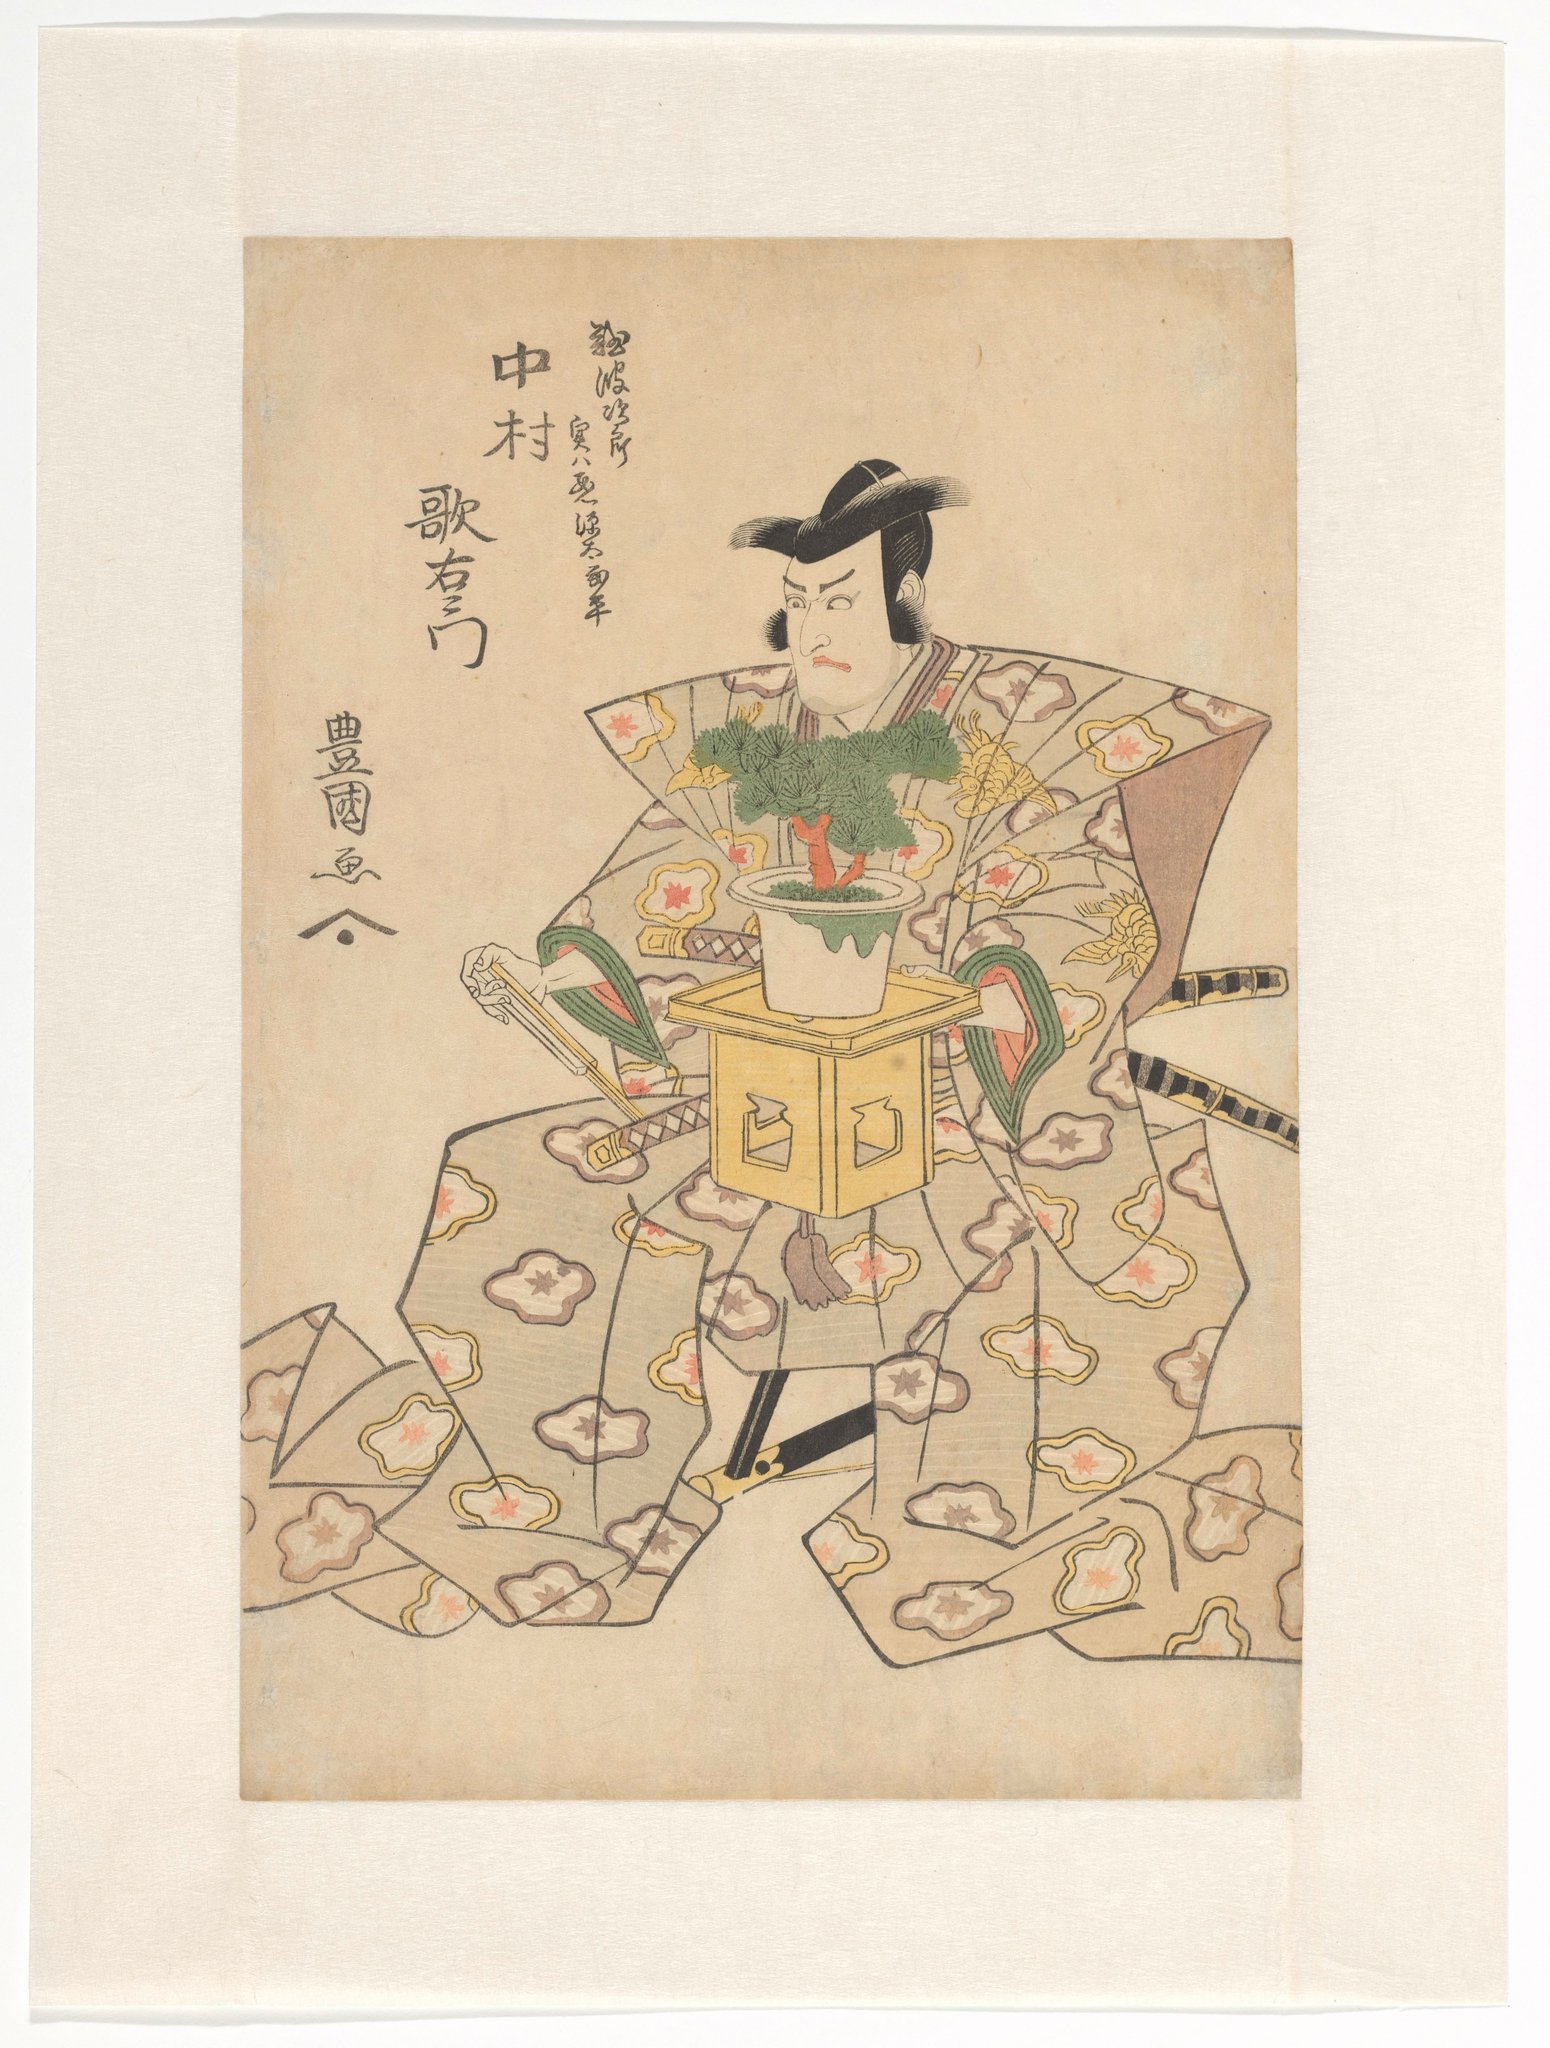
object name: print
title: Nakamura Utaemon III holds bonsai tree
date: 1808-1811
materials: paper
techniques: woodcut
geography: japan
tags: sitting figure, topiary work (shrubs and trees trimmed and trained into ornamental shape); bonsai, espalliered, etc., actor (on the stage)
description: Kabuki acteur Nakamura Utaemon III in de rol van Nanba Jirô, zittend met in zijn handen een bonsai boompje.